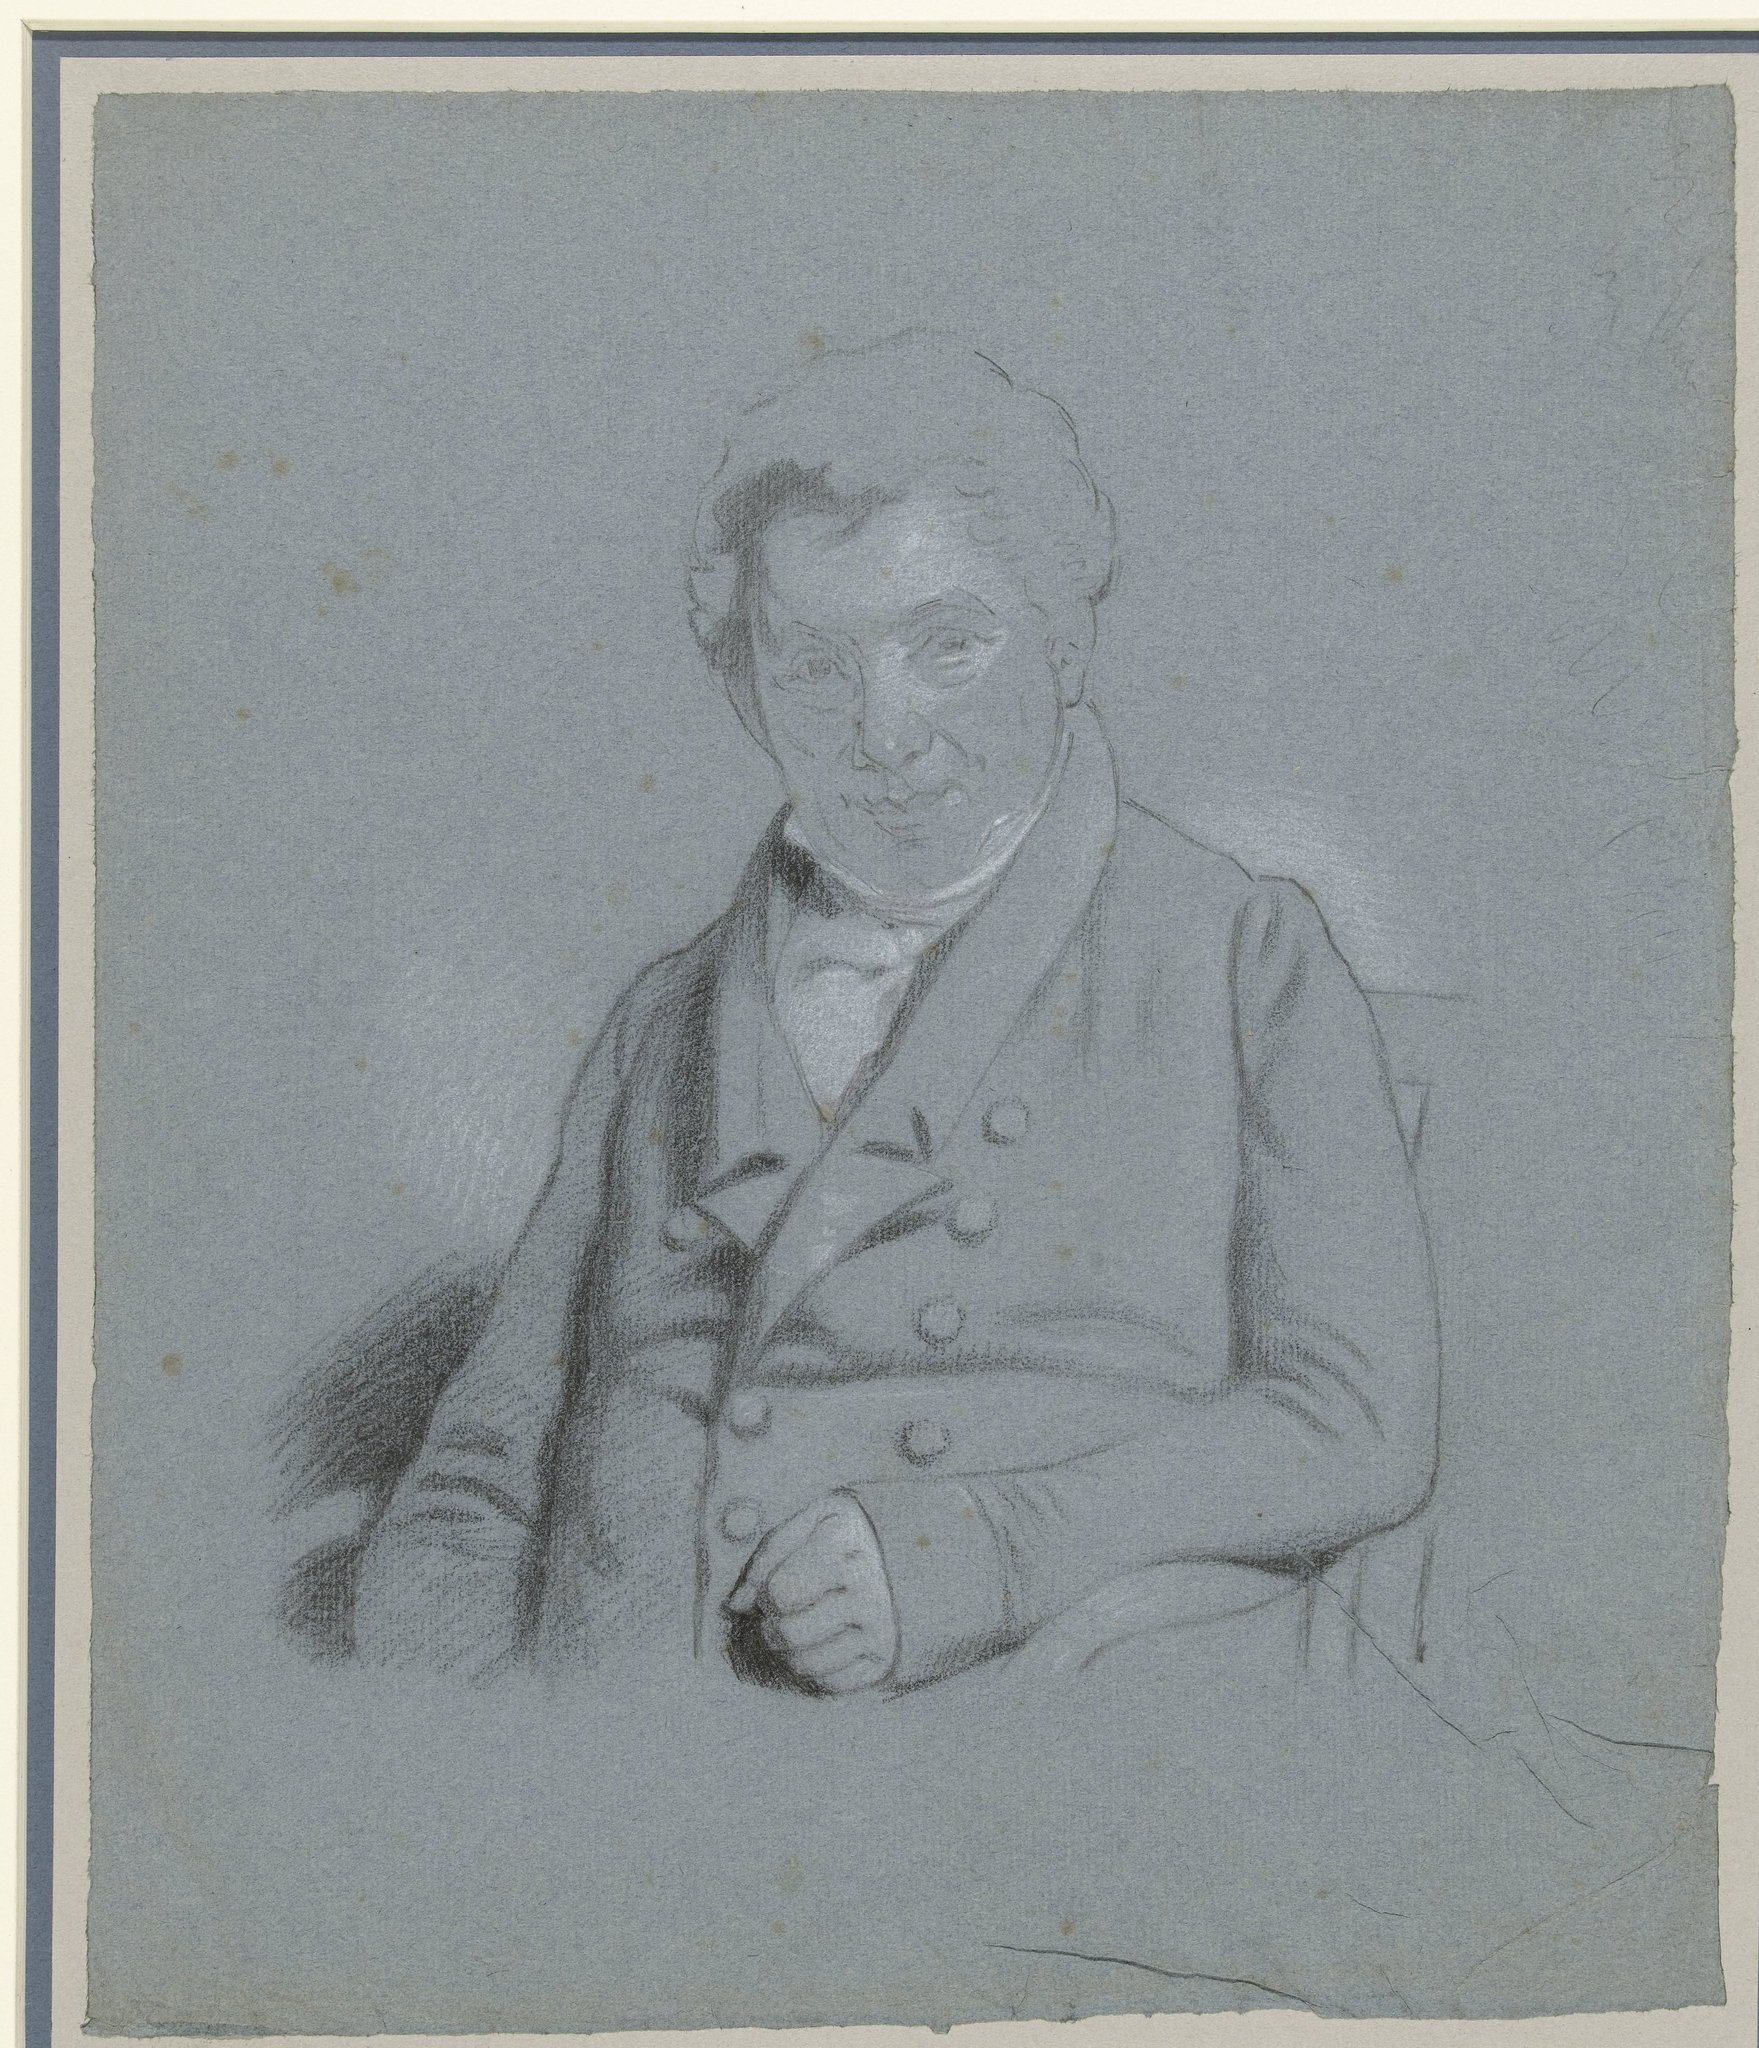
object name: drawing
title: Portret van een onbekende man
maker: charles howard hodges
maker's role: draughtsman, painter, print maker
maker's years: 1764-1837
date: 1774-1837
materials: chalk, paper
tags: anonymous historical person portrayed alone